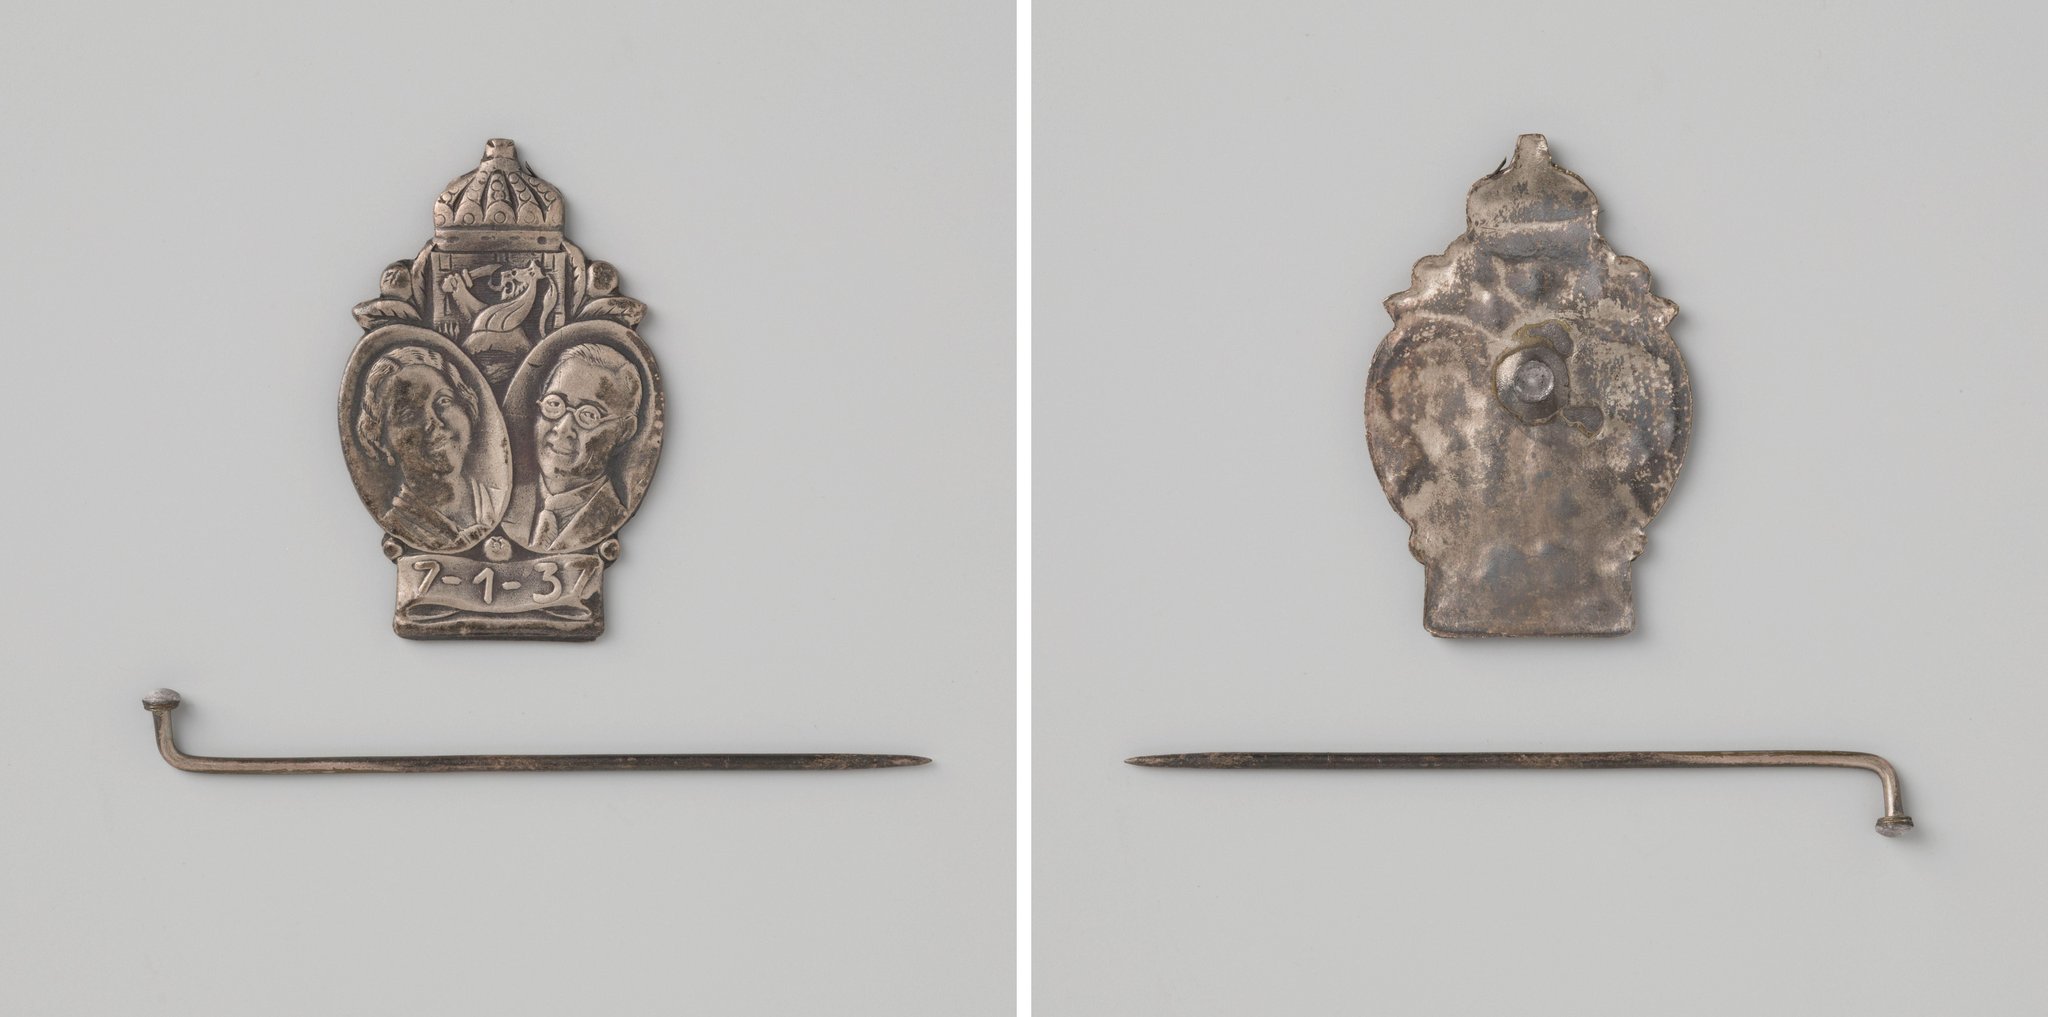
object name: history medal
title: Huwelijk van prinses Juliana en Bernhard van Lippe-Biesterveld 1937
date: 1937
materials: metal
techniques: pressing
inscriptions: inscription: ‘7-1-'37’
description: Verzilverd speldje met twee ovalen medaillons met de borstbeelden van Juliana en Bernhard, onderaan een tekstlint, bovenaan een gekroond Nederlands wapenschild tussen oramjetakken. NB speld afgebroken.